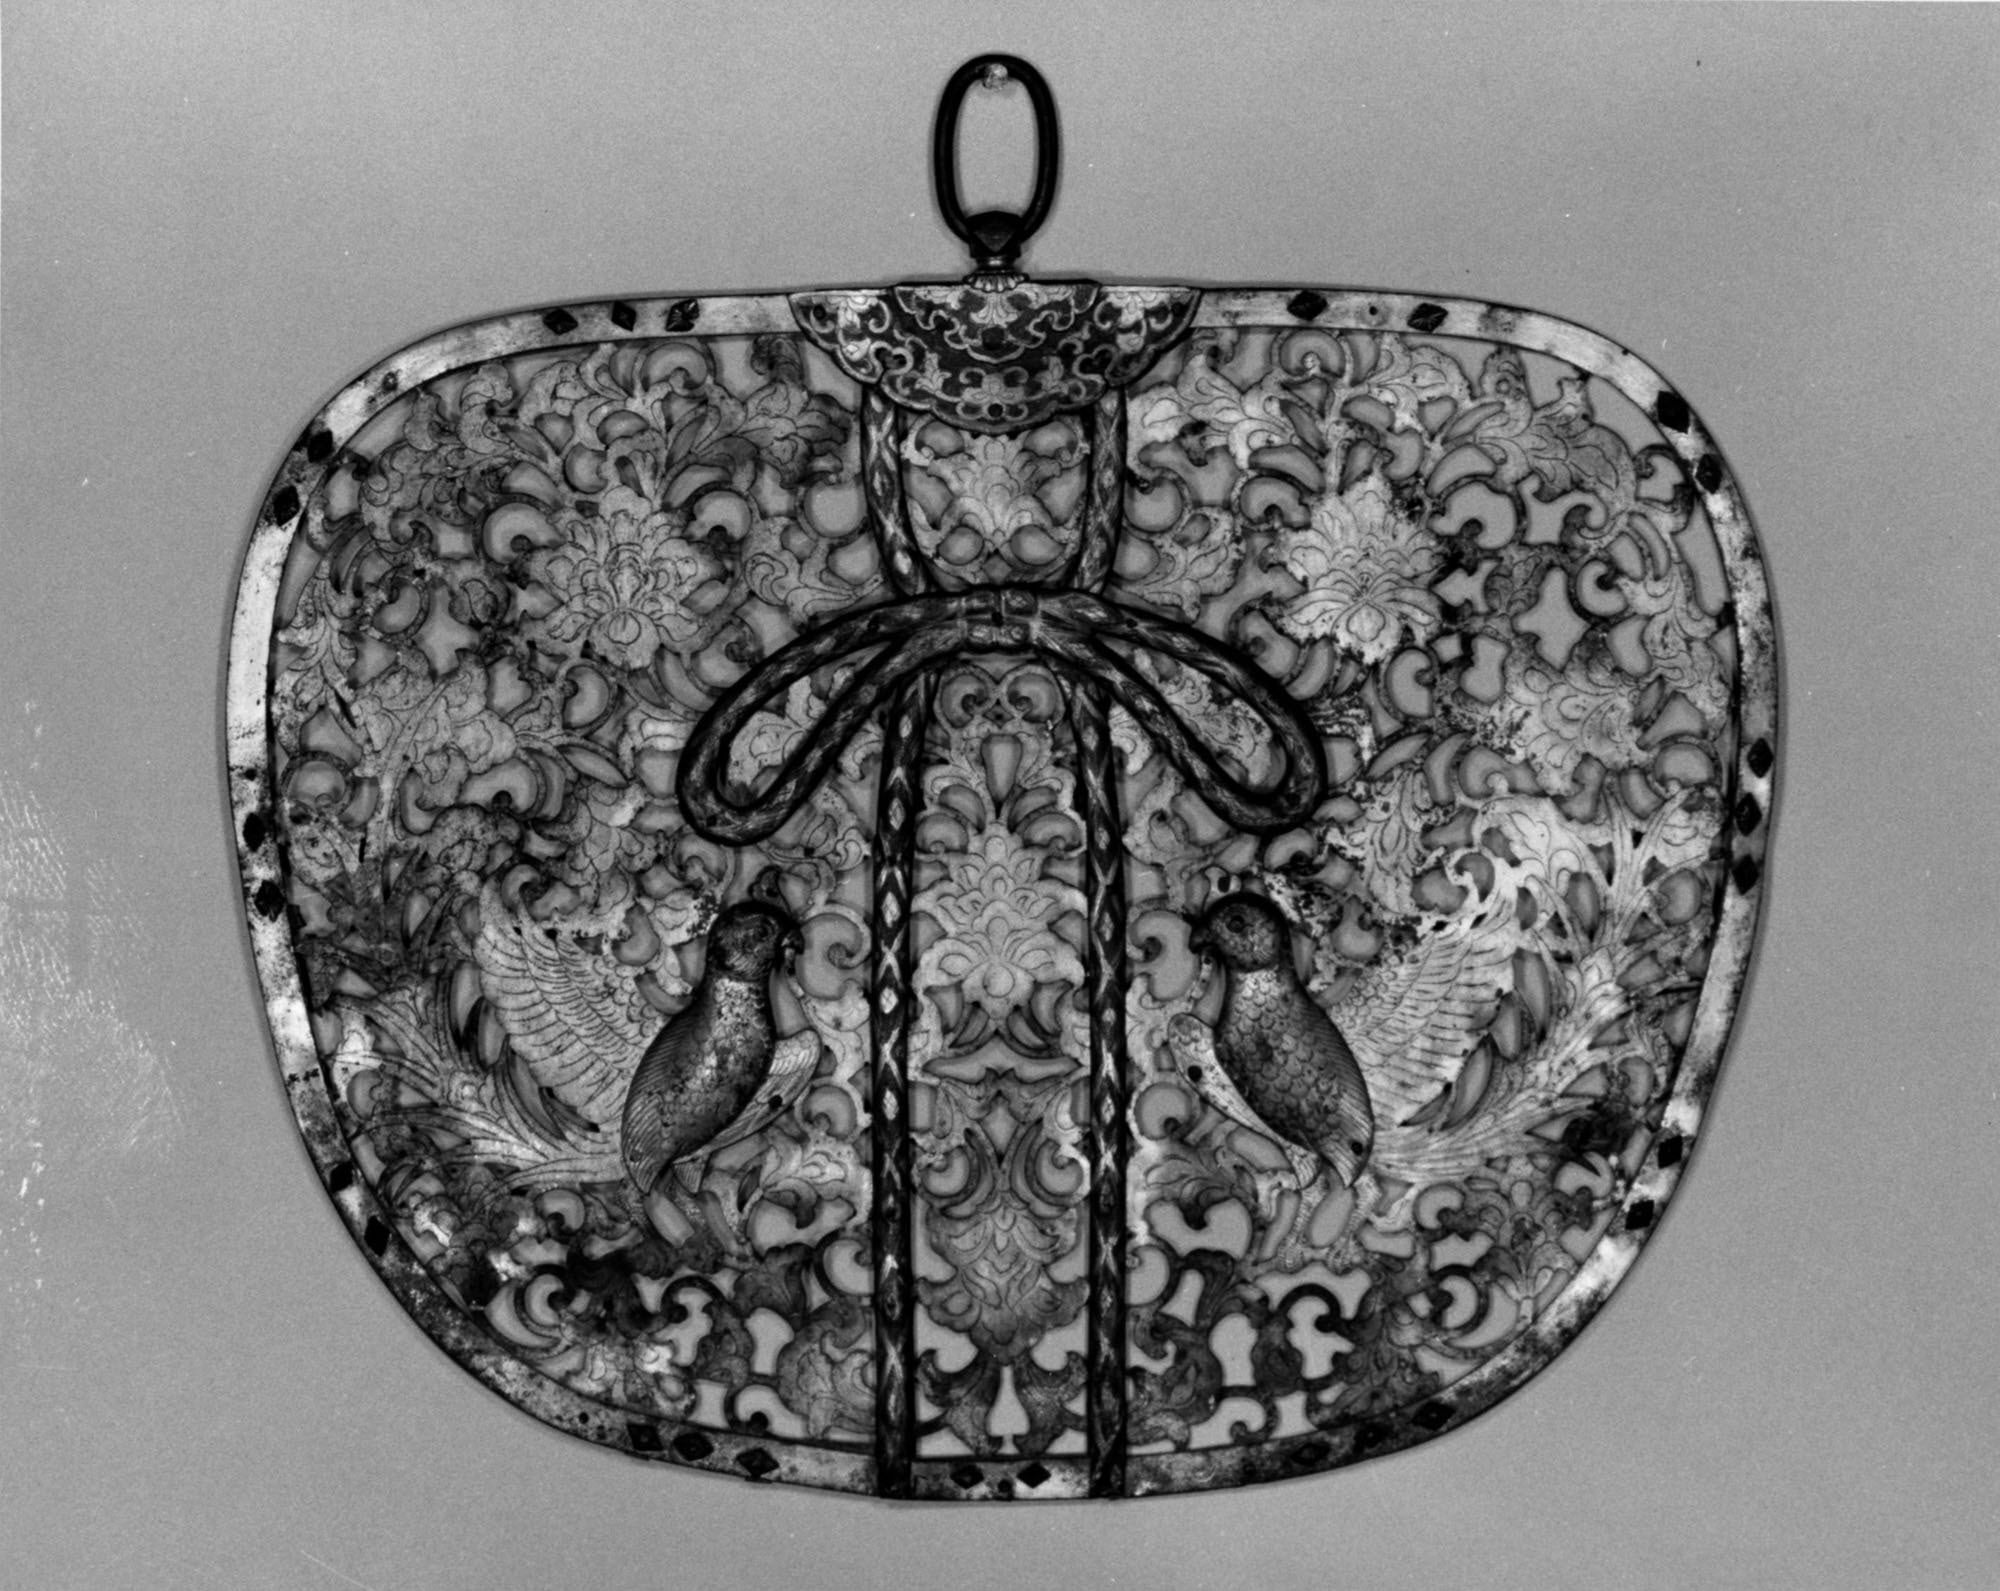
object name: temple hanger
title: Keman (Decorative Pendant Disk)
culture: japanese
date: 1201-1300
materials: gilt bronze, silver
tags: birds,flowers